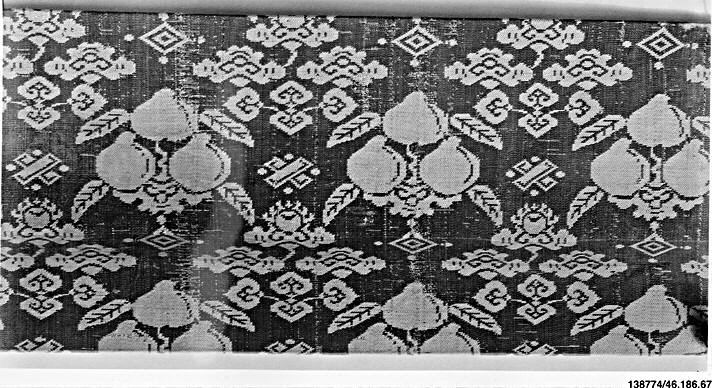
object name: sutra cover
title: Sutra Cover with Peaches and Auspicious Symbols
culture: chinese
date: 1501-1633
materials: silk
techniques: damask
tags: peaches